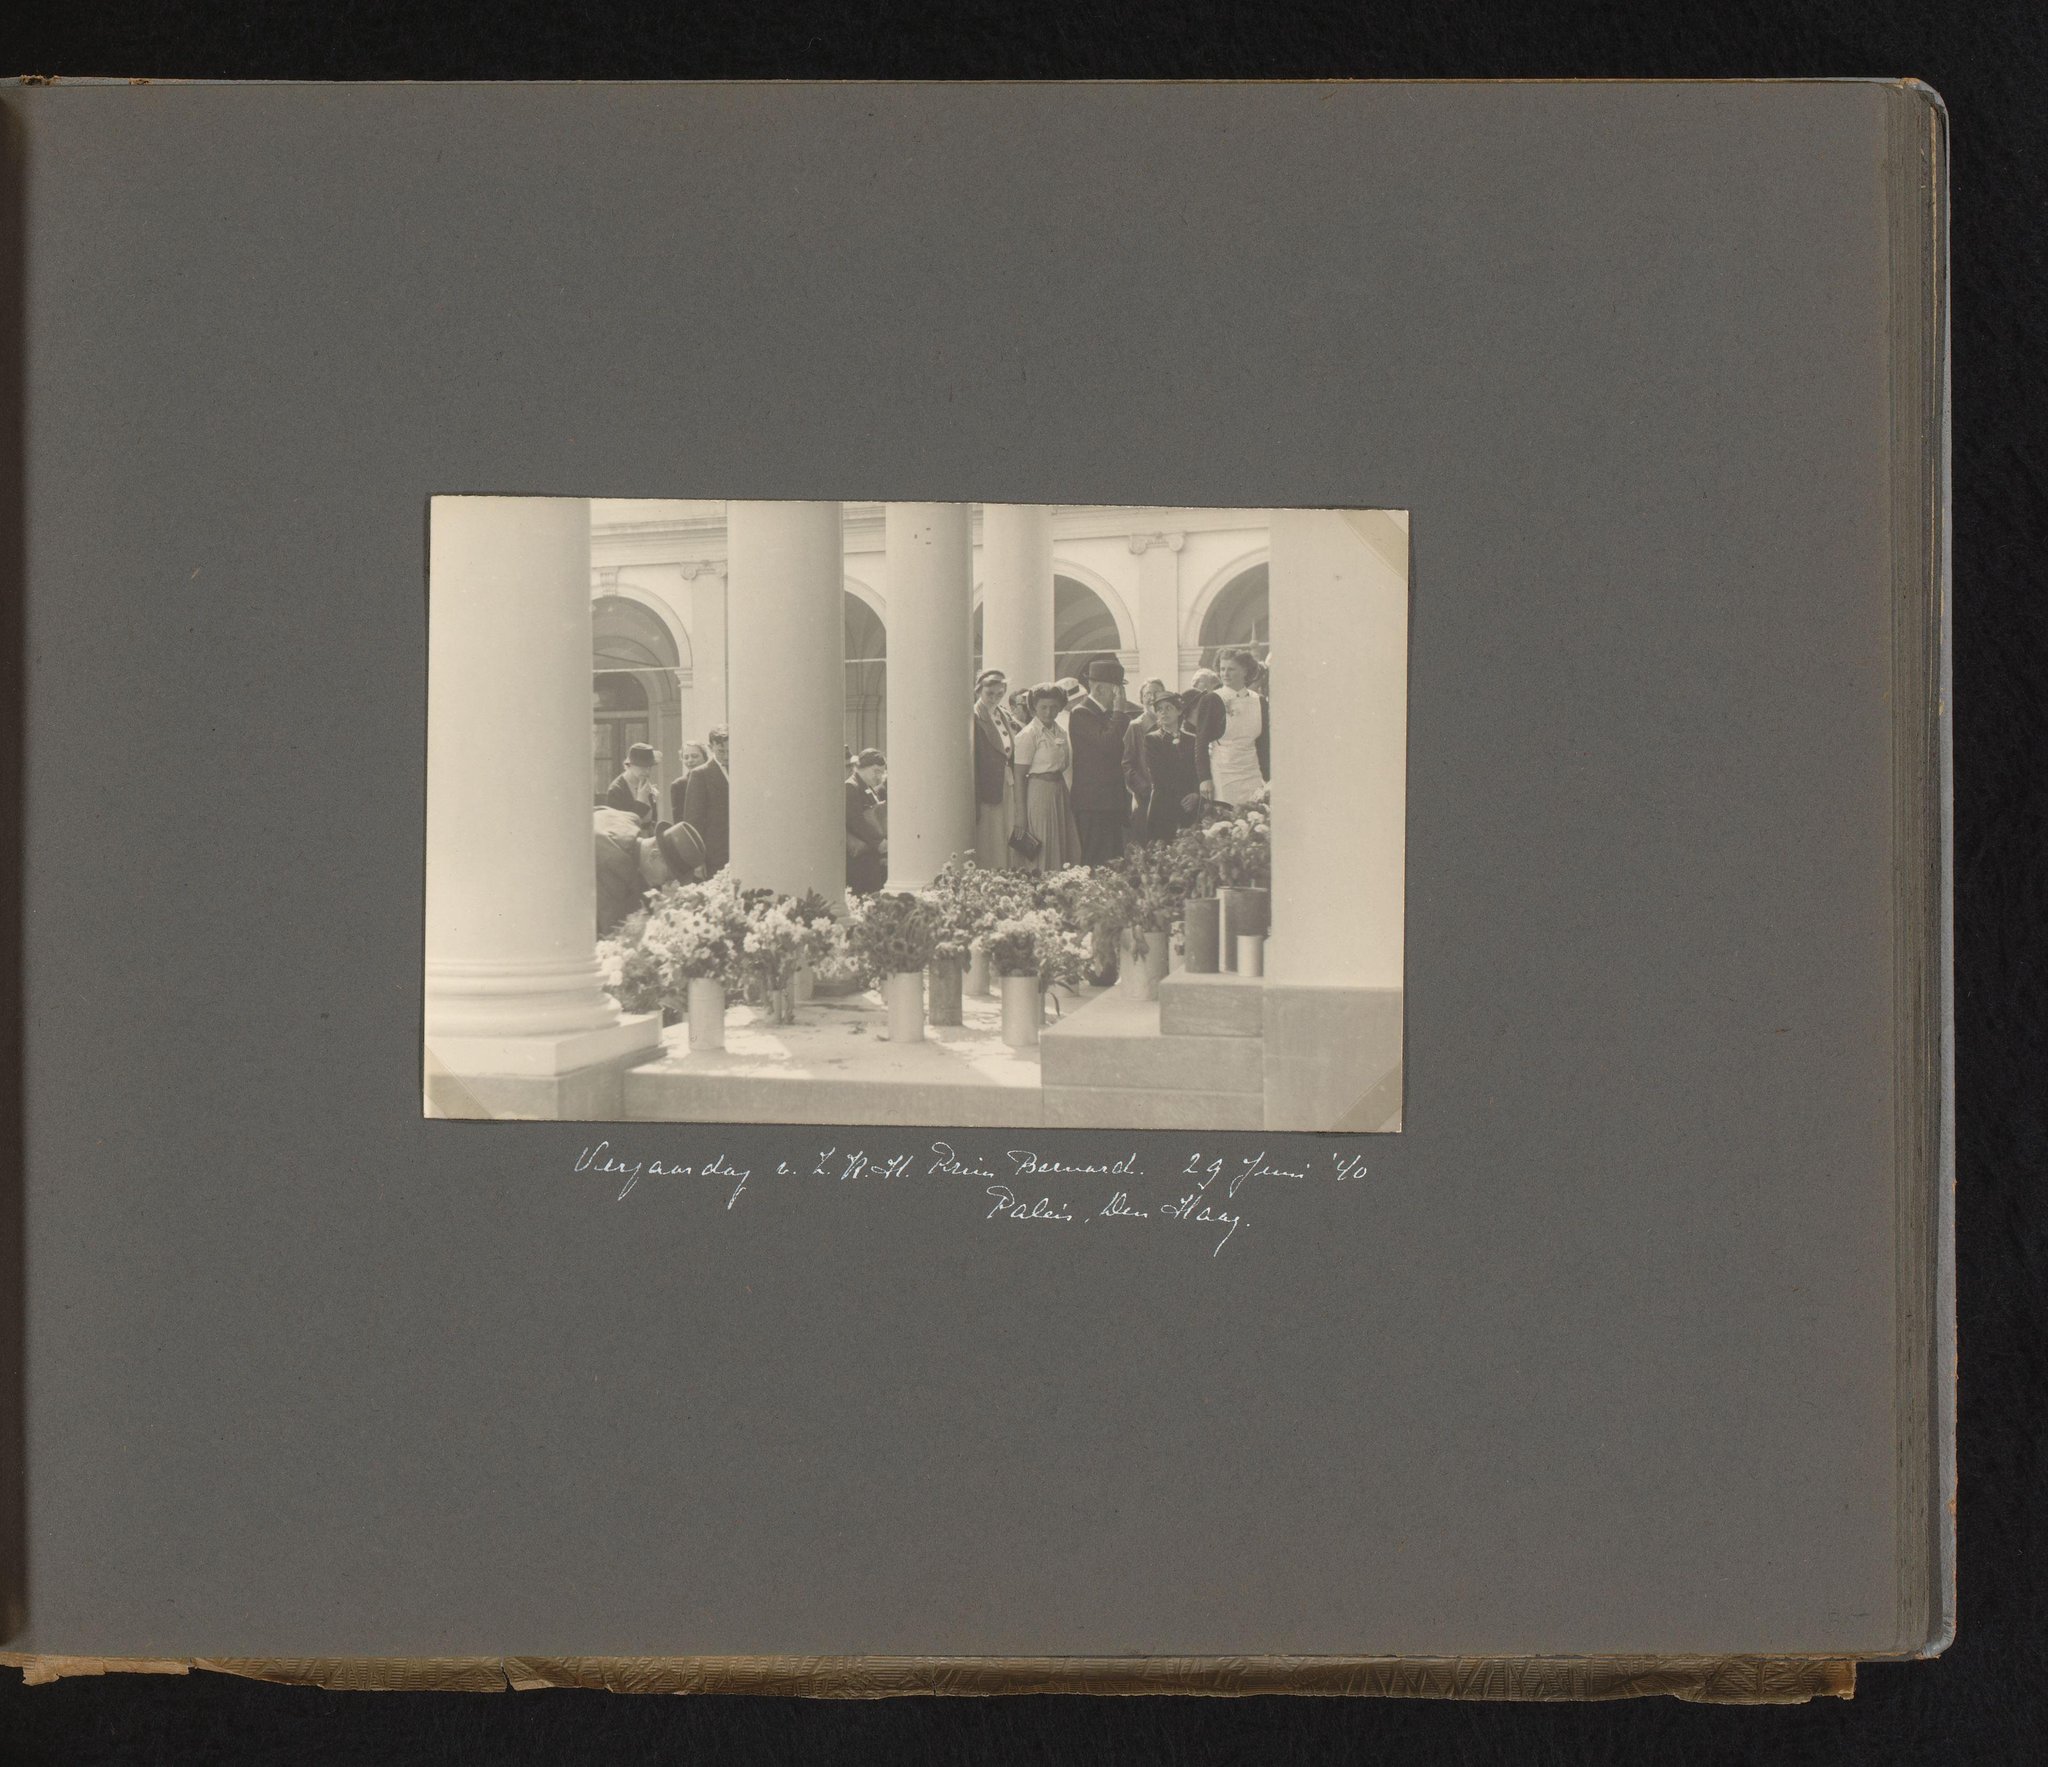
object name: ansichtkaart, prentbriefkaart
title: Verjaardag van prins Bernhard, 29 juni 1940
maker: Anonymous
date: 1940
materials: cardboard, photographic support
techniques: gelatin silver print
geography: the hague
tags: utrecht, bernhard (prins der nederlanden), public festivities at other royal events, not meant or mentioned above, the hague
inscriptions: inscription: ‘Verjaardag v. Z.K.H. Prins Bernard. 29 JUni '40 Paleis, Den Haag’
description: Albumblad met een foto van gasten en bloemenzee bij de verjaardag van prins Bernhard, Den Haag, 29 juni 1940. Onderdeel van fotoalbum over het familieleven van de leden van het Koninklijk Huis tussen 1937-1945.